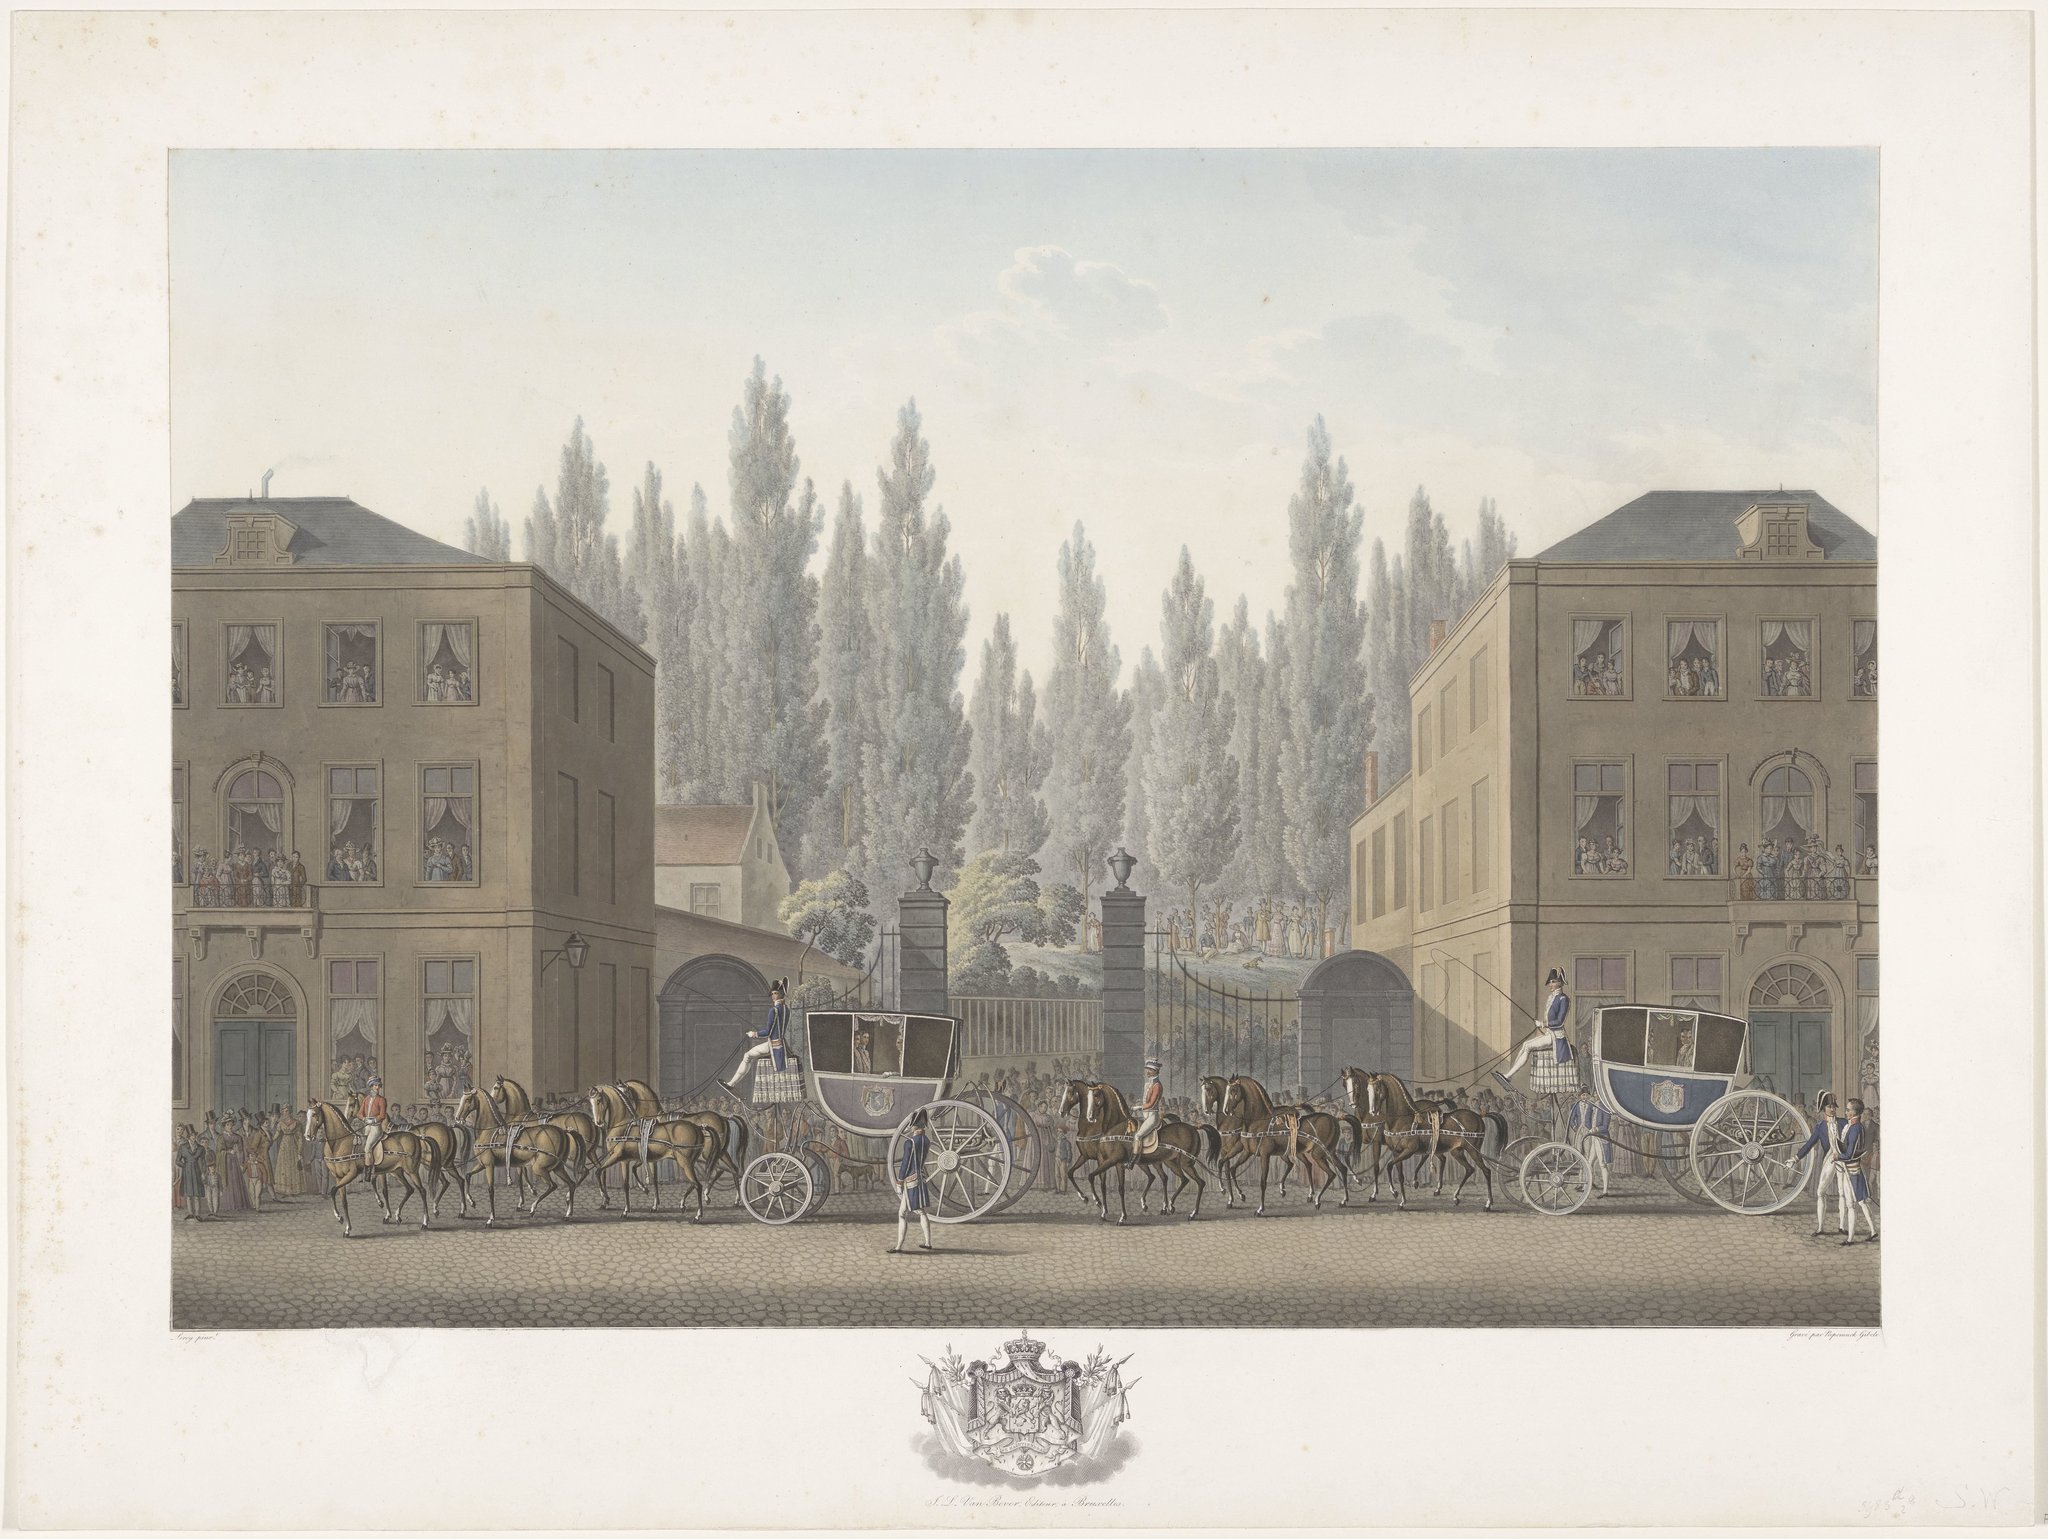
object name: history print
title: Twee koetsen in de stoet voor de inhuldiging van Willem I te Brussel op 21 september 1815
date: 1825-1826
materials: paper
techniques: aquatint, etching, hand coloring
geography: brussels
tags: the hague, william i of the netherlands, triumphal entry and public reception, pageant, 'entrée solennelle', 'joyeuse entrée', brussels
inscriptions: collector's mark: Lugt 2228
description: Plechtige intrede van de stoet voor de inhuldiging van koning Willem I te Brussel op 21 september 1815. Twee hofkoetsen, ieder met zes paarden. Onderaan het wapen van koning Willem I. Onderdeel van een serie platen van de aankomst en inhuldiging van Willem I in Brussel.